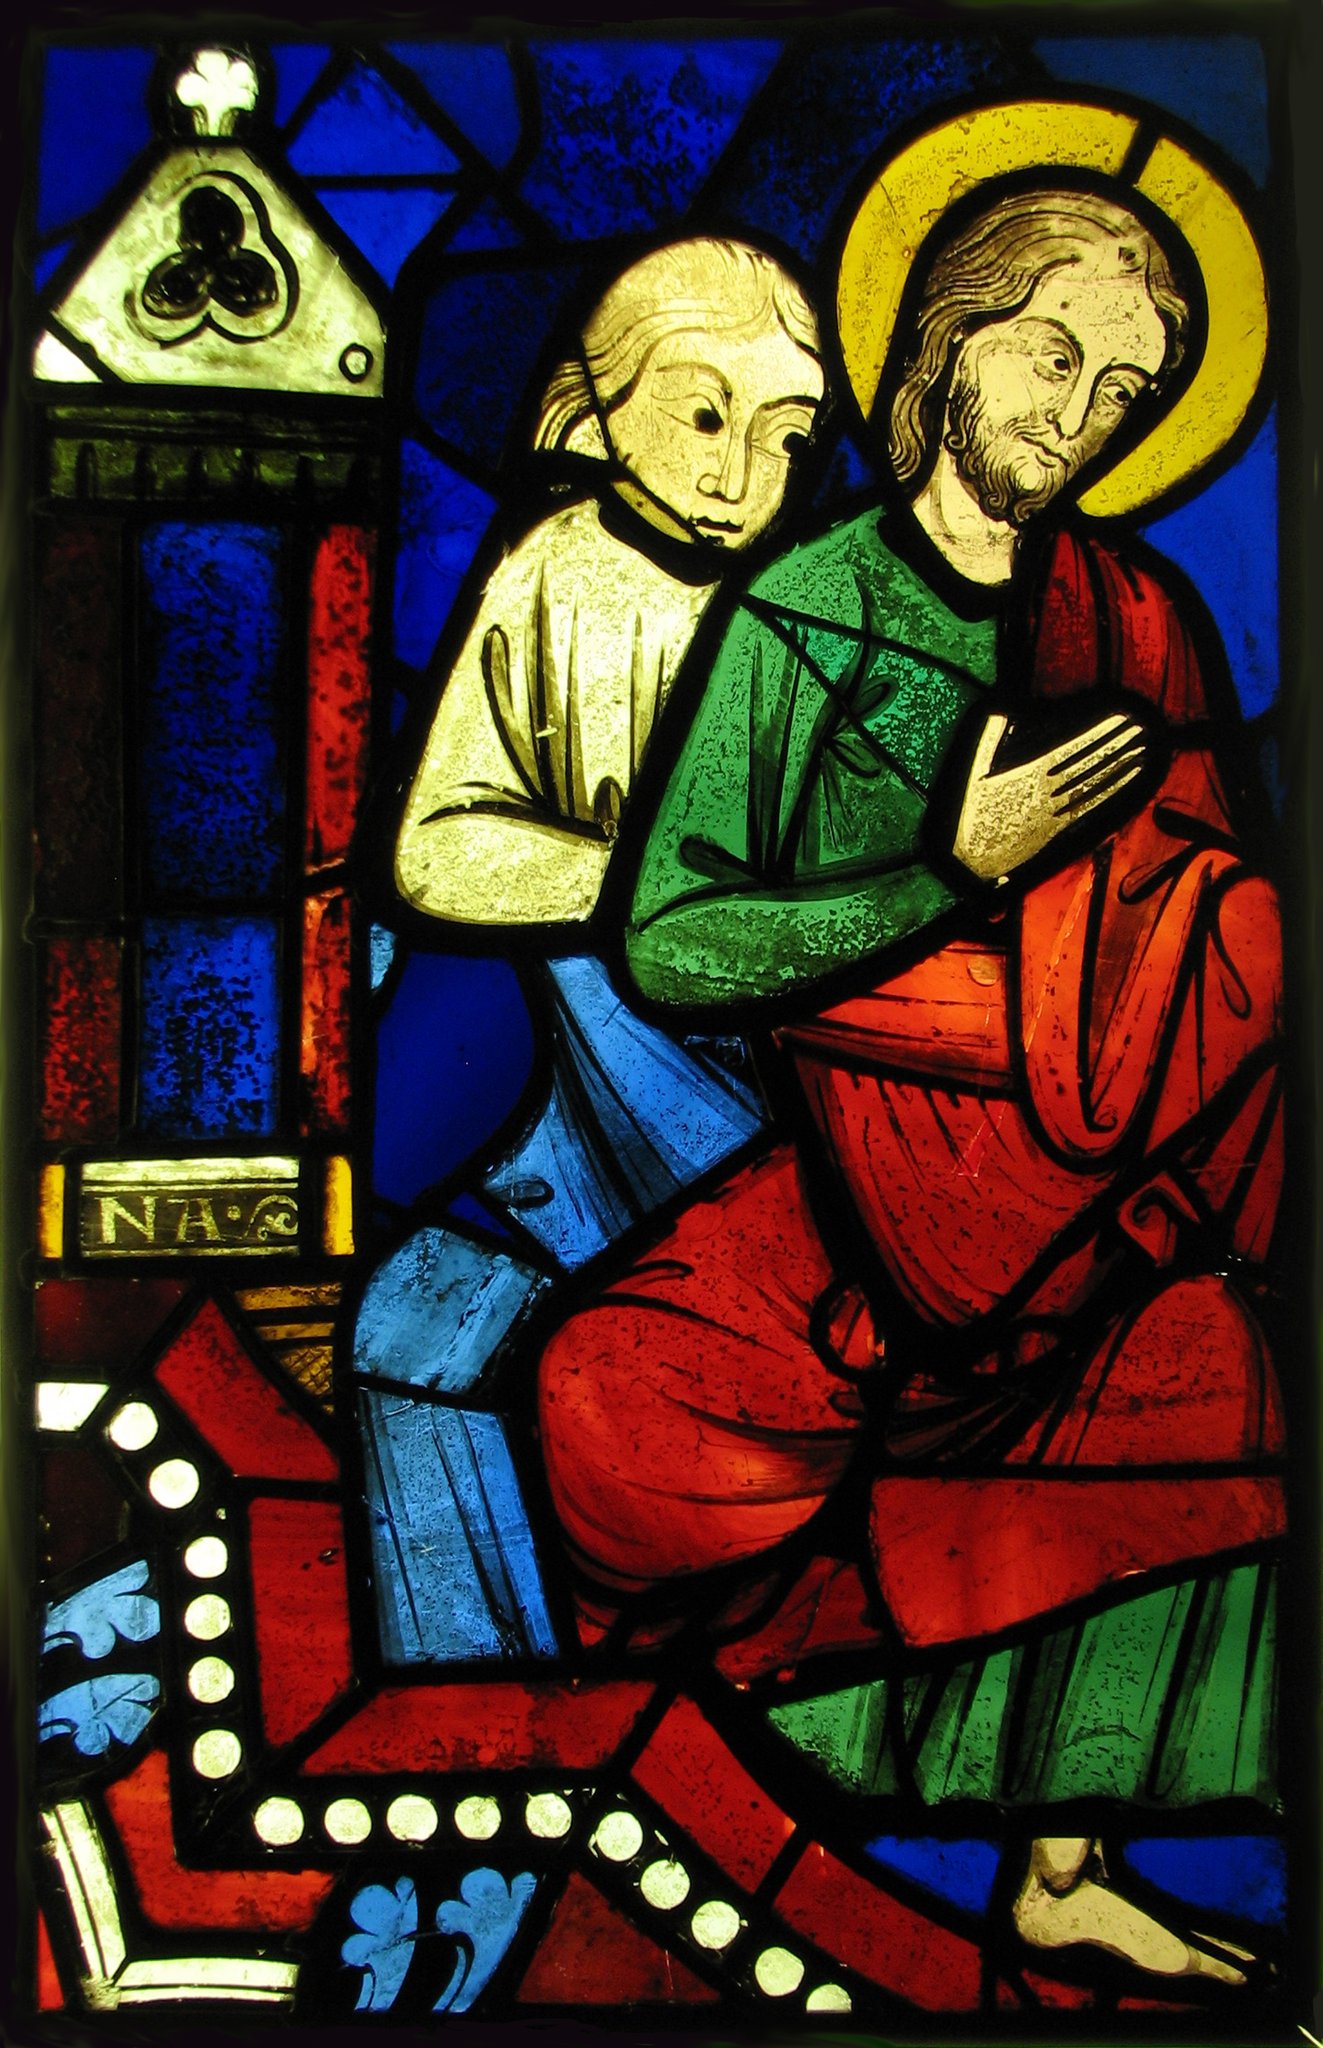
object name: panel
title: Two Seated Apostles from a Pentecost Scene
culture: french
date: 1245-1248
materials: glass, metal, paint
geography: france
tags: men,apostles